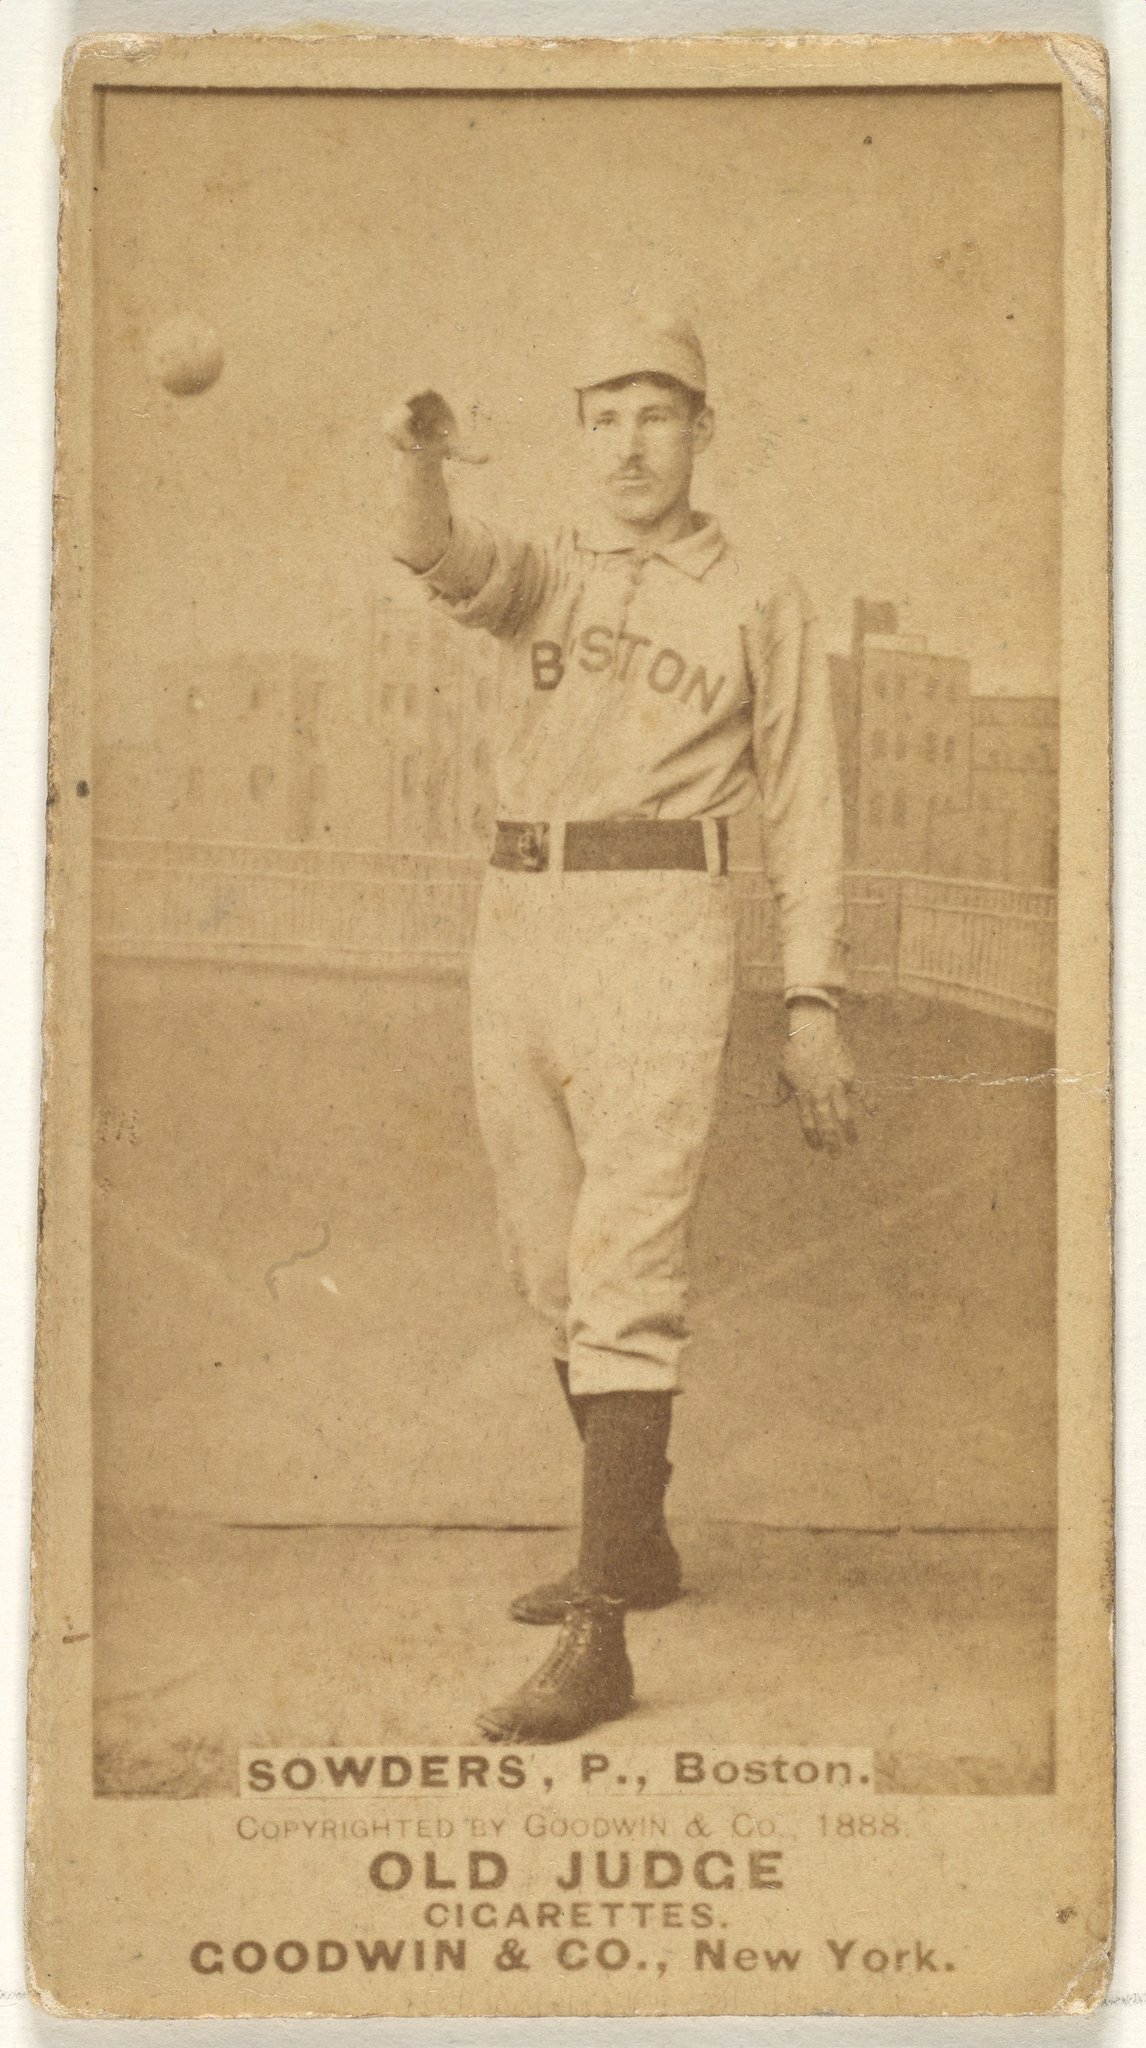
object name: baseball card, photograph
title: Sowders, Pitcher, Boston, from the Old Judge series (N172) for Old Judge Cigarettes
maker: goodwin & company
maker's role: publisher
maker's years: 1850-1950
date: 1888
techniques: albumen silver print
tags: men,portraits,baseball,athletes